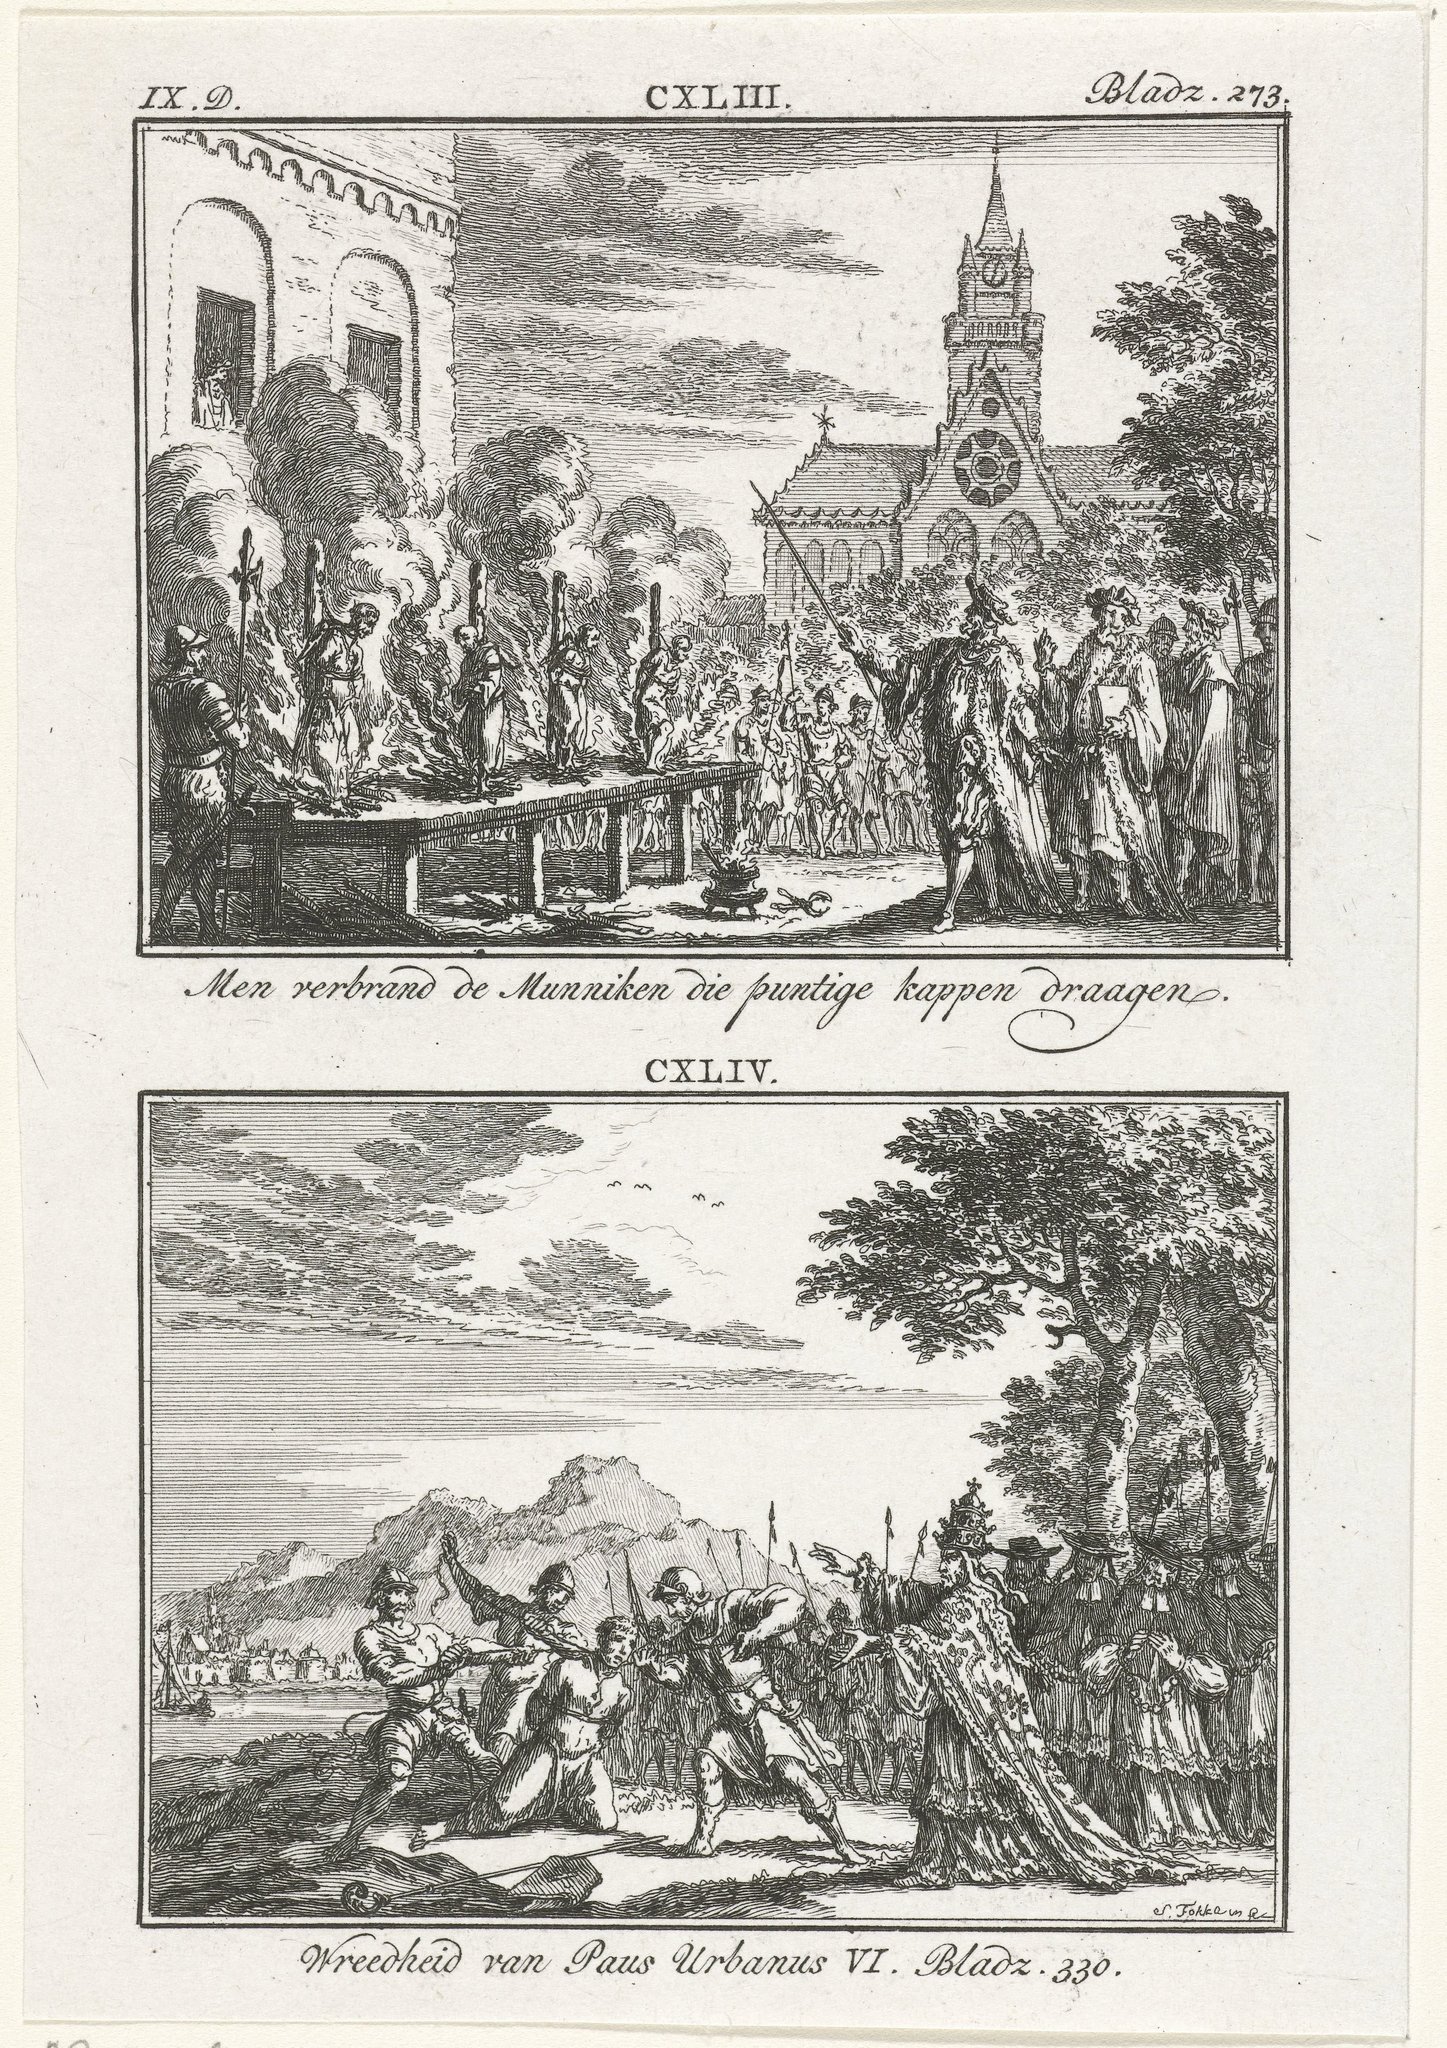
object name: book illustration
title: Illustratie voor de wereldgeschiedenis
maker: simon fokke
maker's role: draughtsman, print maker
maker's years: 1712-1784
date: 1722-1784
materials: paper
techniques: etching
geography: amsterdam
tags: naples, rome, monk(s), friar(s), corporal punishment in public, violent death, being killed; being mishandled and maltreated; seeking death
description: Voorstellingen uit de wereldgeschiedenis. Boven: Op een podium in de buitenlucht worden vier monniken aan de schandpaal verbrand. Onder: Onder bevel van paus Urbanus VI kelen drie soldaten een man. Twee voorstellingen van één plaat, respectievelijk genummerd: CXLIII en CCXLIV. Het blad is linksboven gemerkt: IX.D.